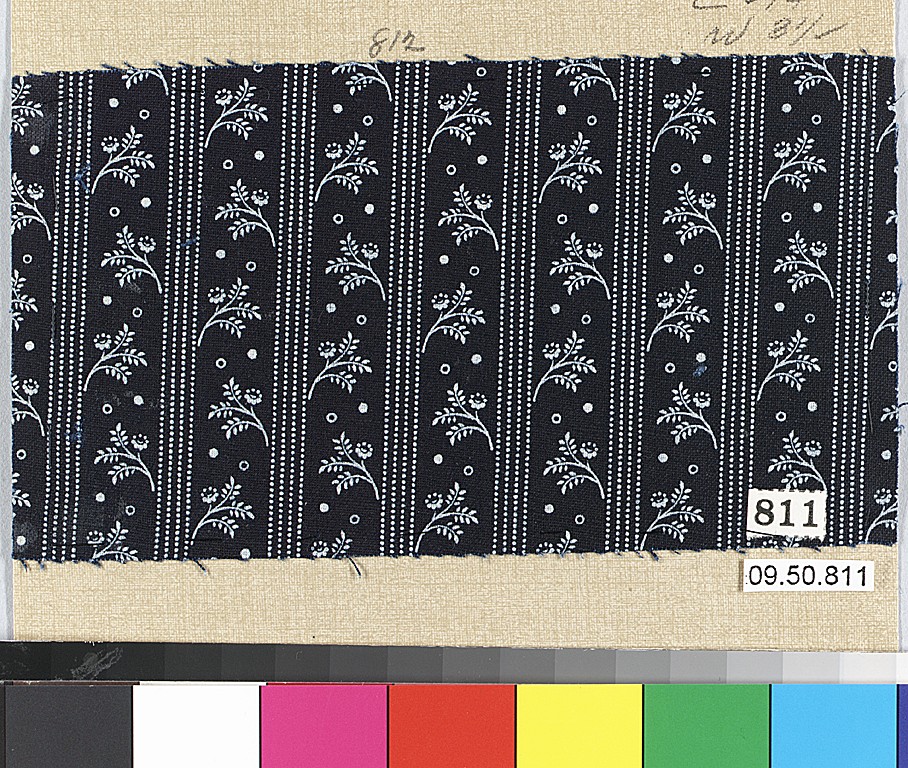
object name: piece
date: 1801-1900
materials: cotton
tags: flowers,leaves